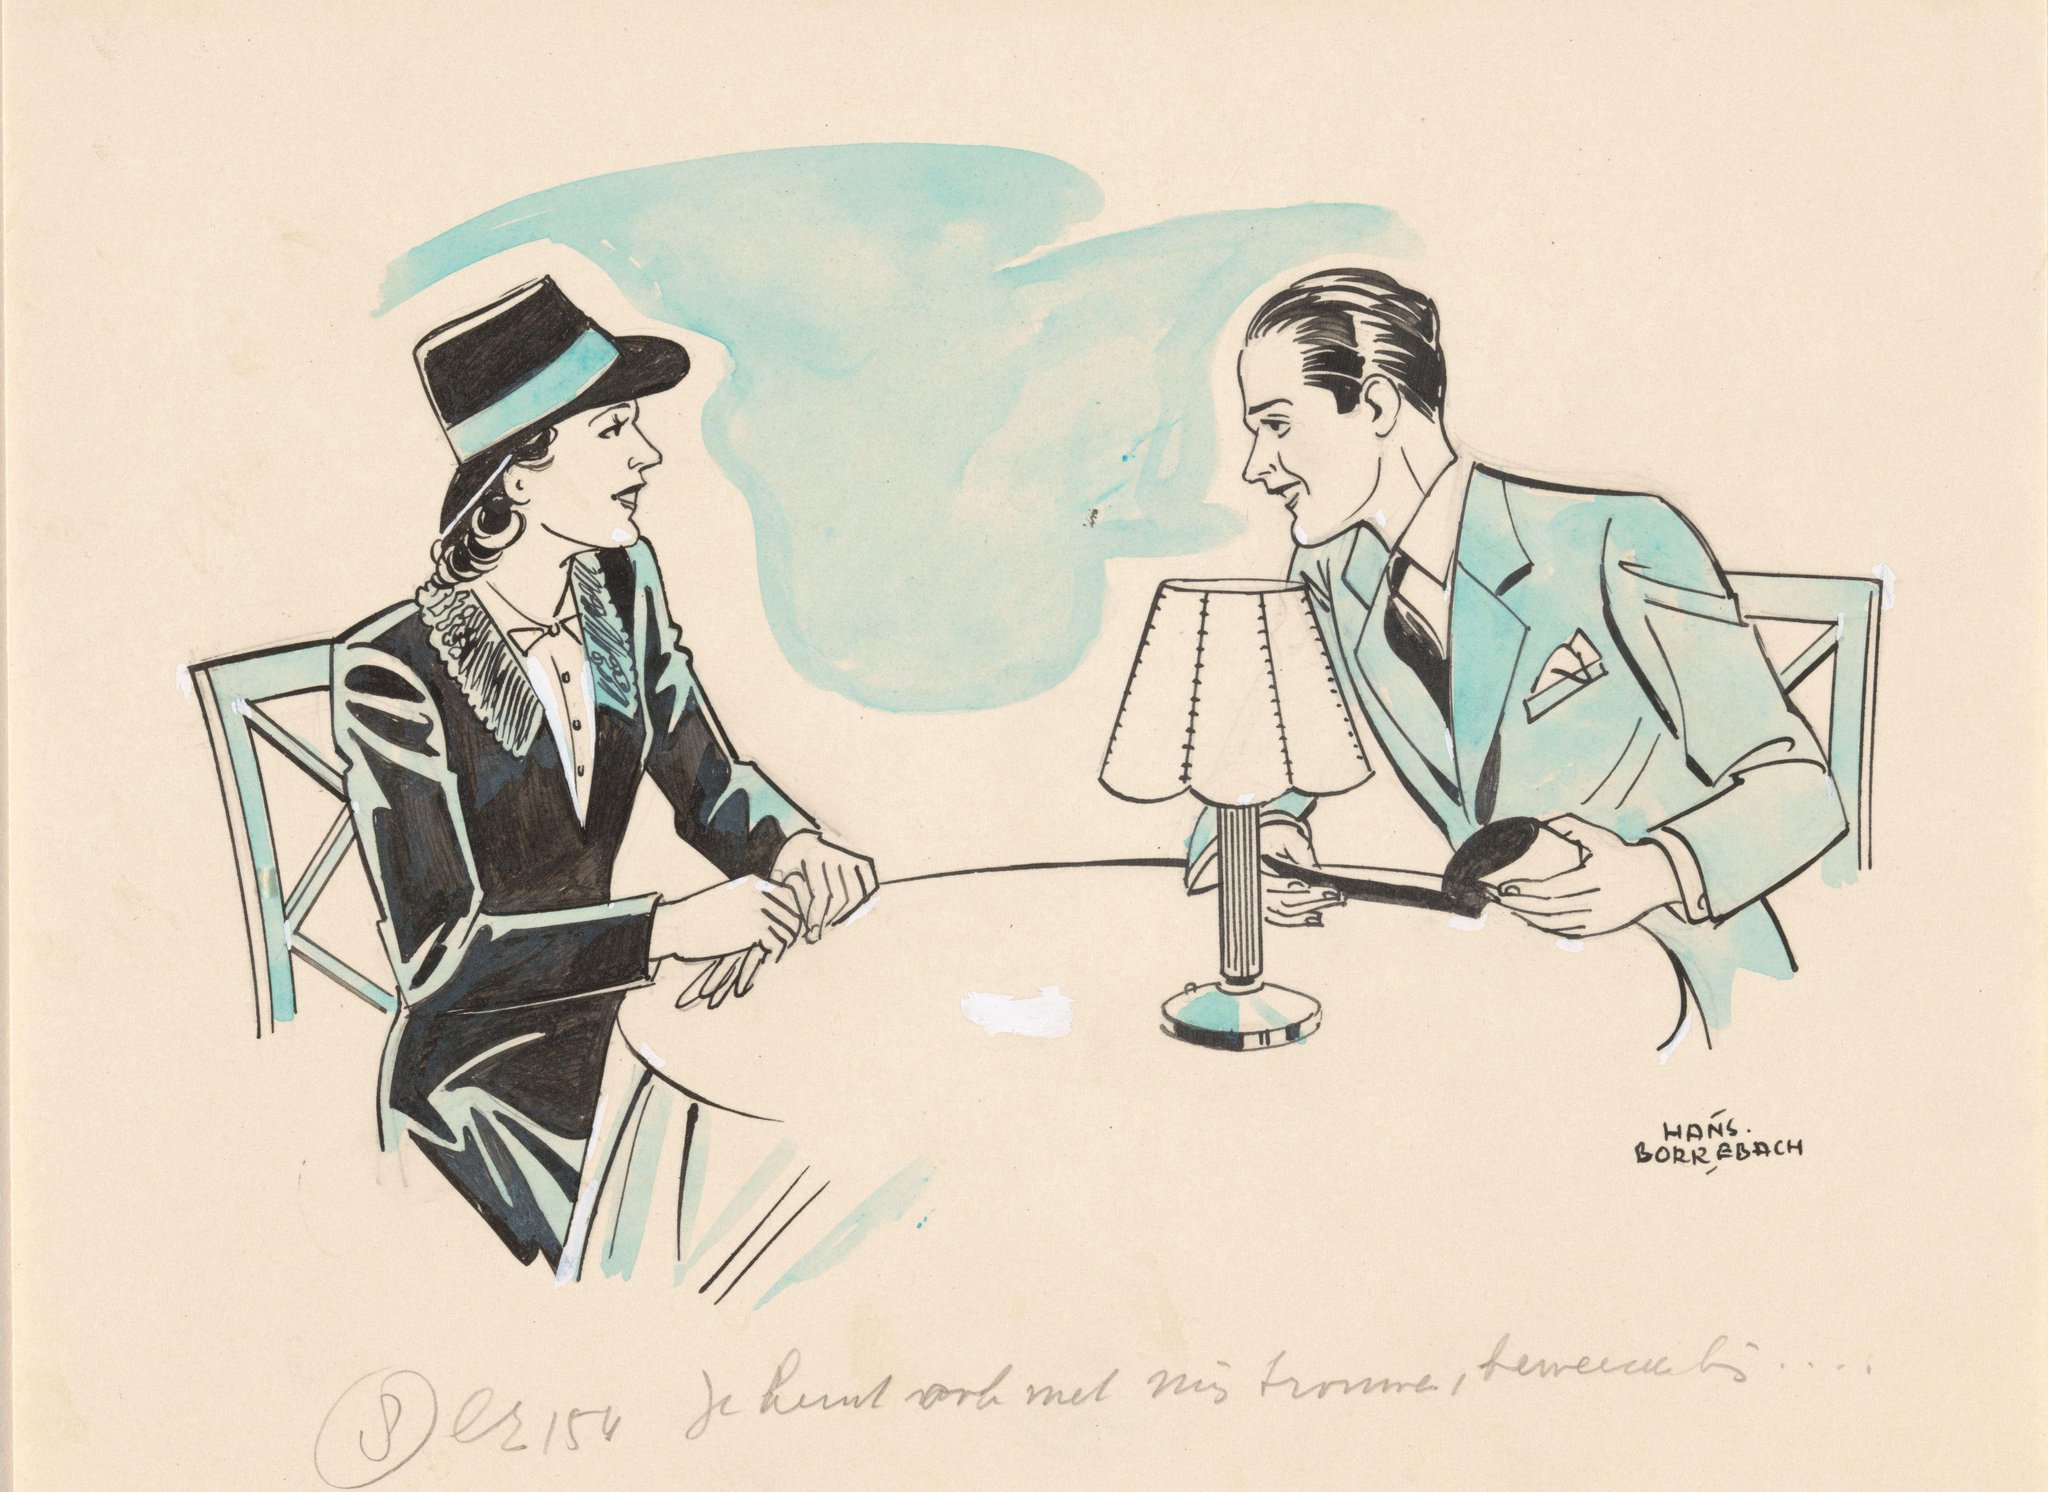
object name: boekillustratie ontwerp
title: Man en vrouw aan een tafel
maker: hans borrebach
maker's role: draughtsman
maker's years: 1903-1991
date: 1940-1945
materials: paint, ink, paper, pencil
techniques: brush, pen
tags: gloves, mittens, etc., table-cloth, electric lamp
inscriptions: collector's mark: ‘R:MVS’, annotation: ‘8 blz 154 Je kunt ook met mij trouwen, beweerde hij ....’, signature: ‘HANS./ BORREBACH’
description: Een man in een pak en een vrouw met een hoed op zitten aan een met een tafelkleed overdekte tafel. Op de tafel staat een schemerlamp. De vrouw heeft haar handschoenen op tafel gelegd en houdt deze vast. De man heeft een papier, mogelijk een menukaart, in de hand en leunt met zijn bovenlichaam richting de vrouw.